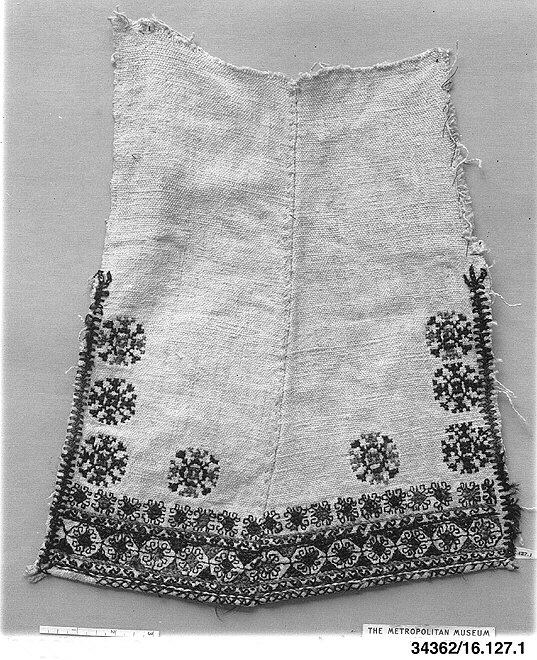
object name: piece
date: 1801-1900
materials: linen, wool